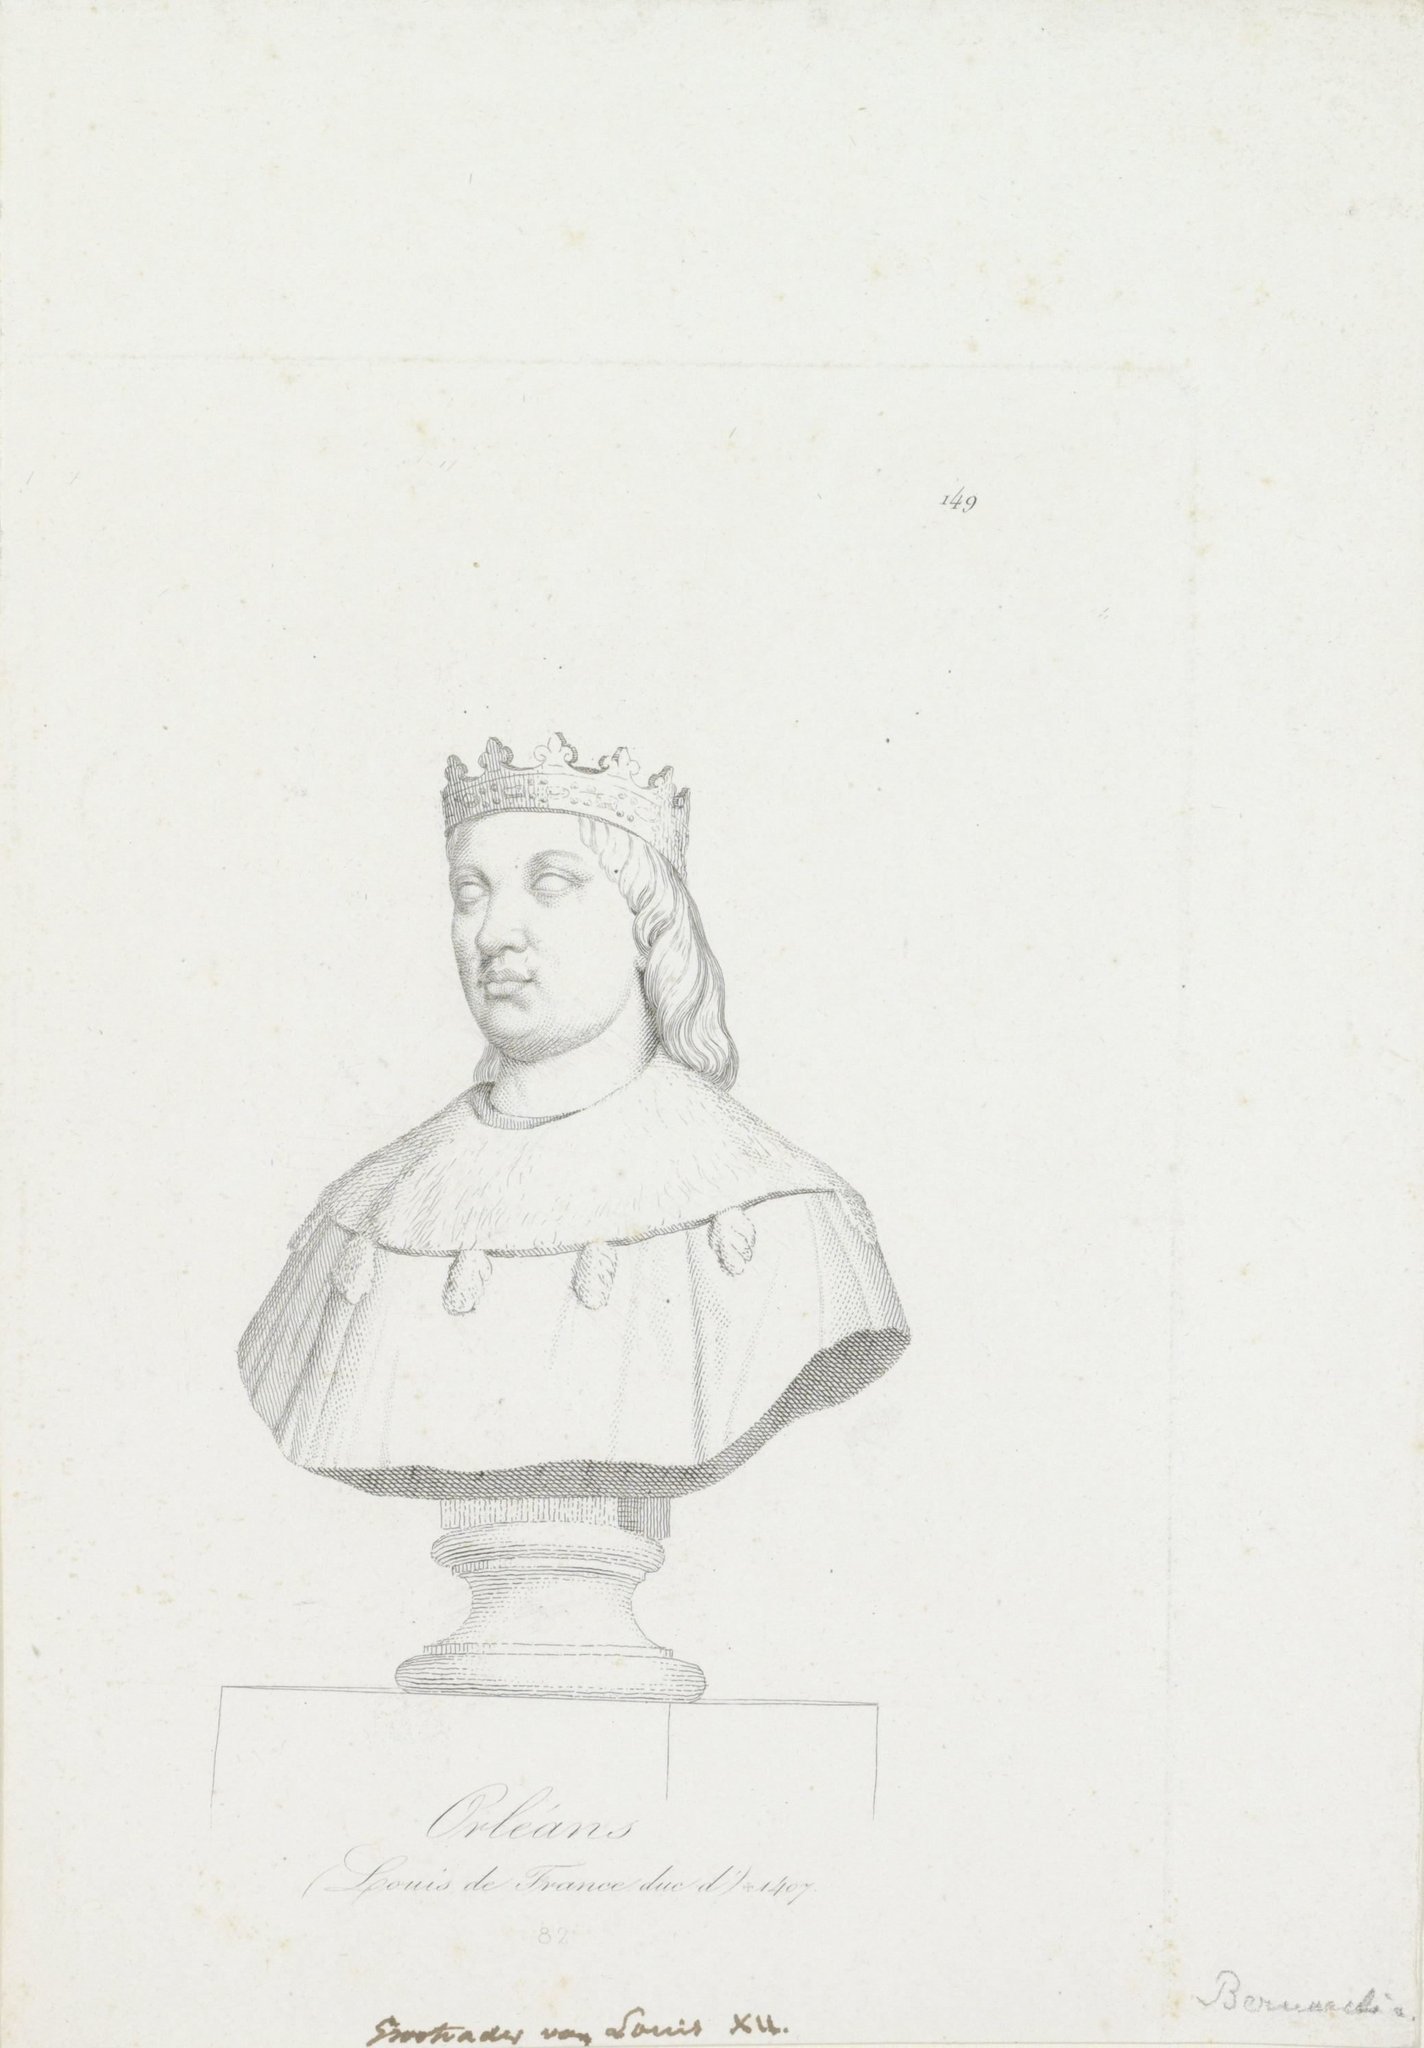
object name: print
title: Galerie historique de Versailles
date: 1818-1848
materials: paper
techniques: engraving, etching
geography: paris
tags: paris, earl, historical persons, piece of sculpture, reproduction of a piece of sculpture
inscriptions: collector's mark: Lugt 2228